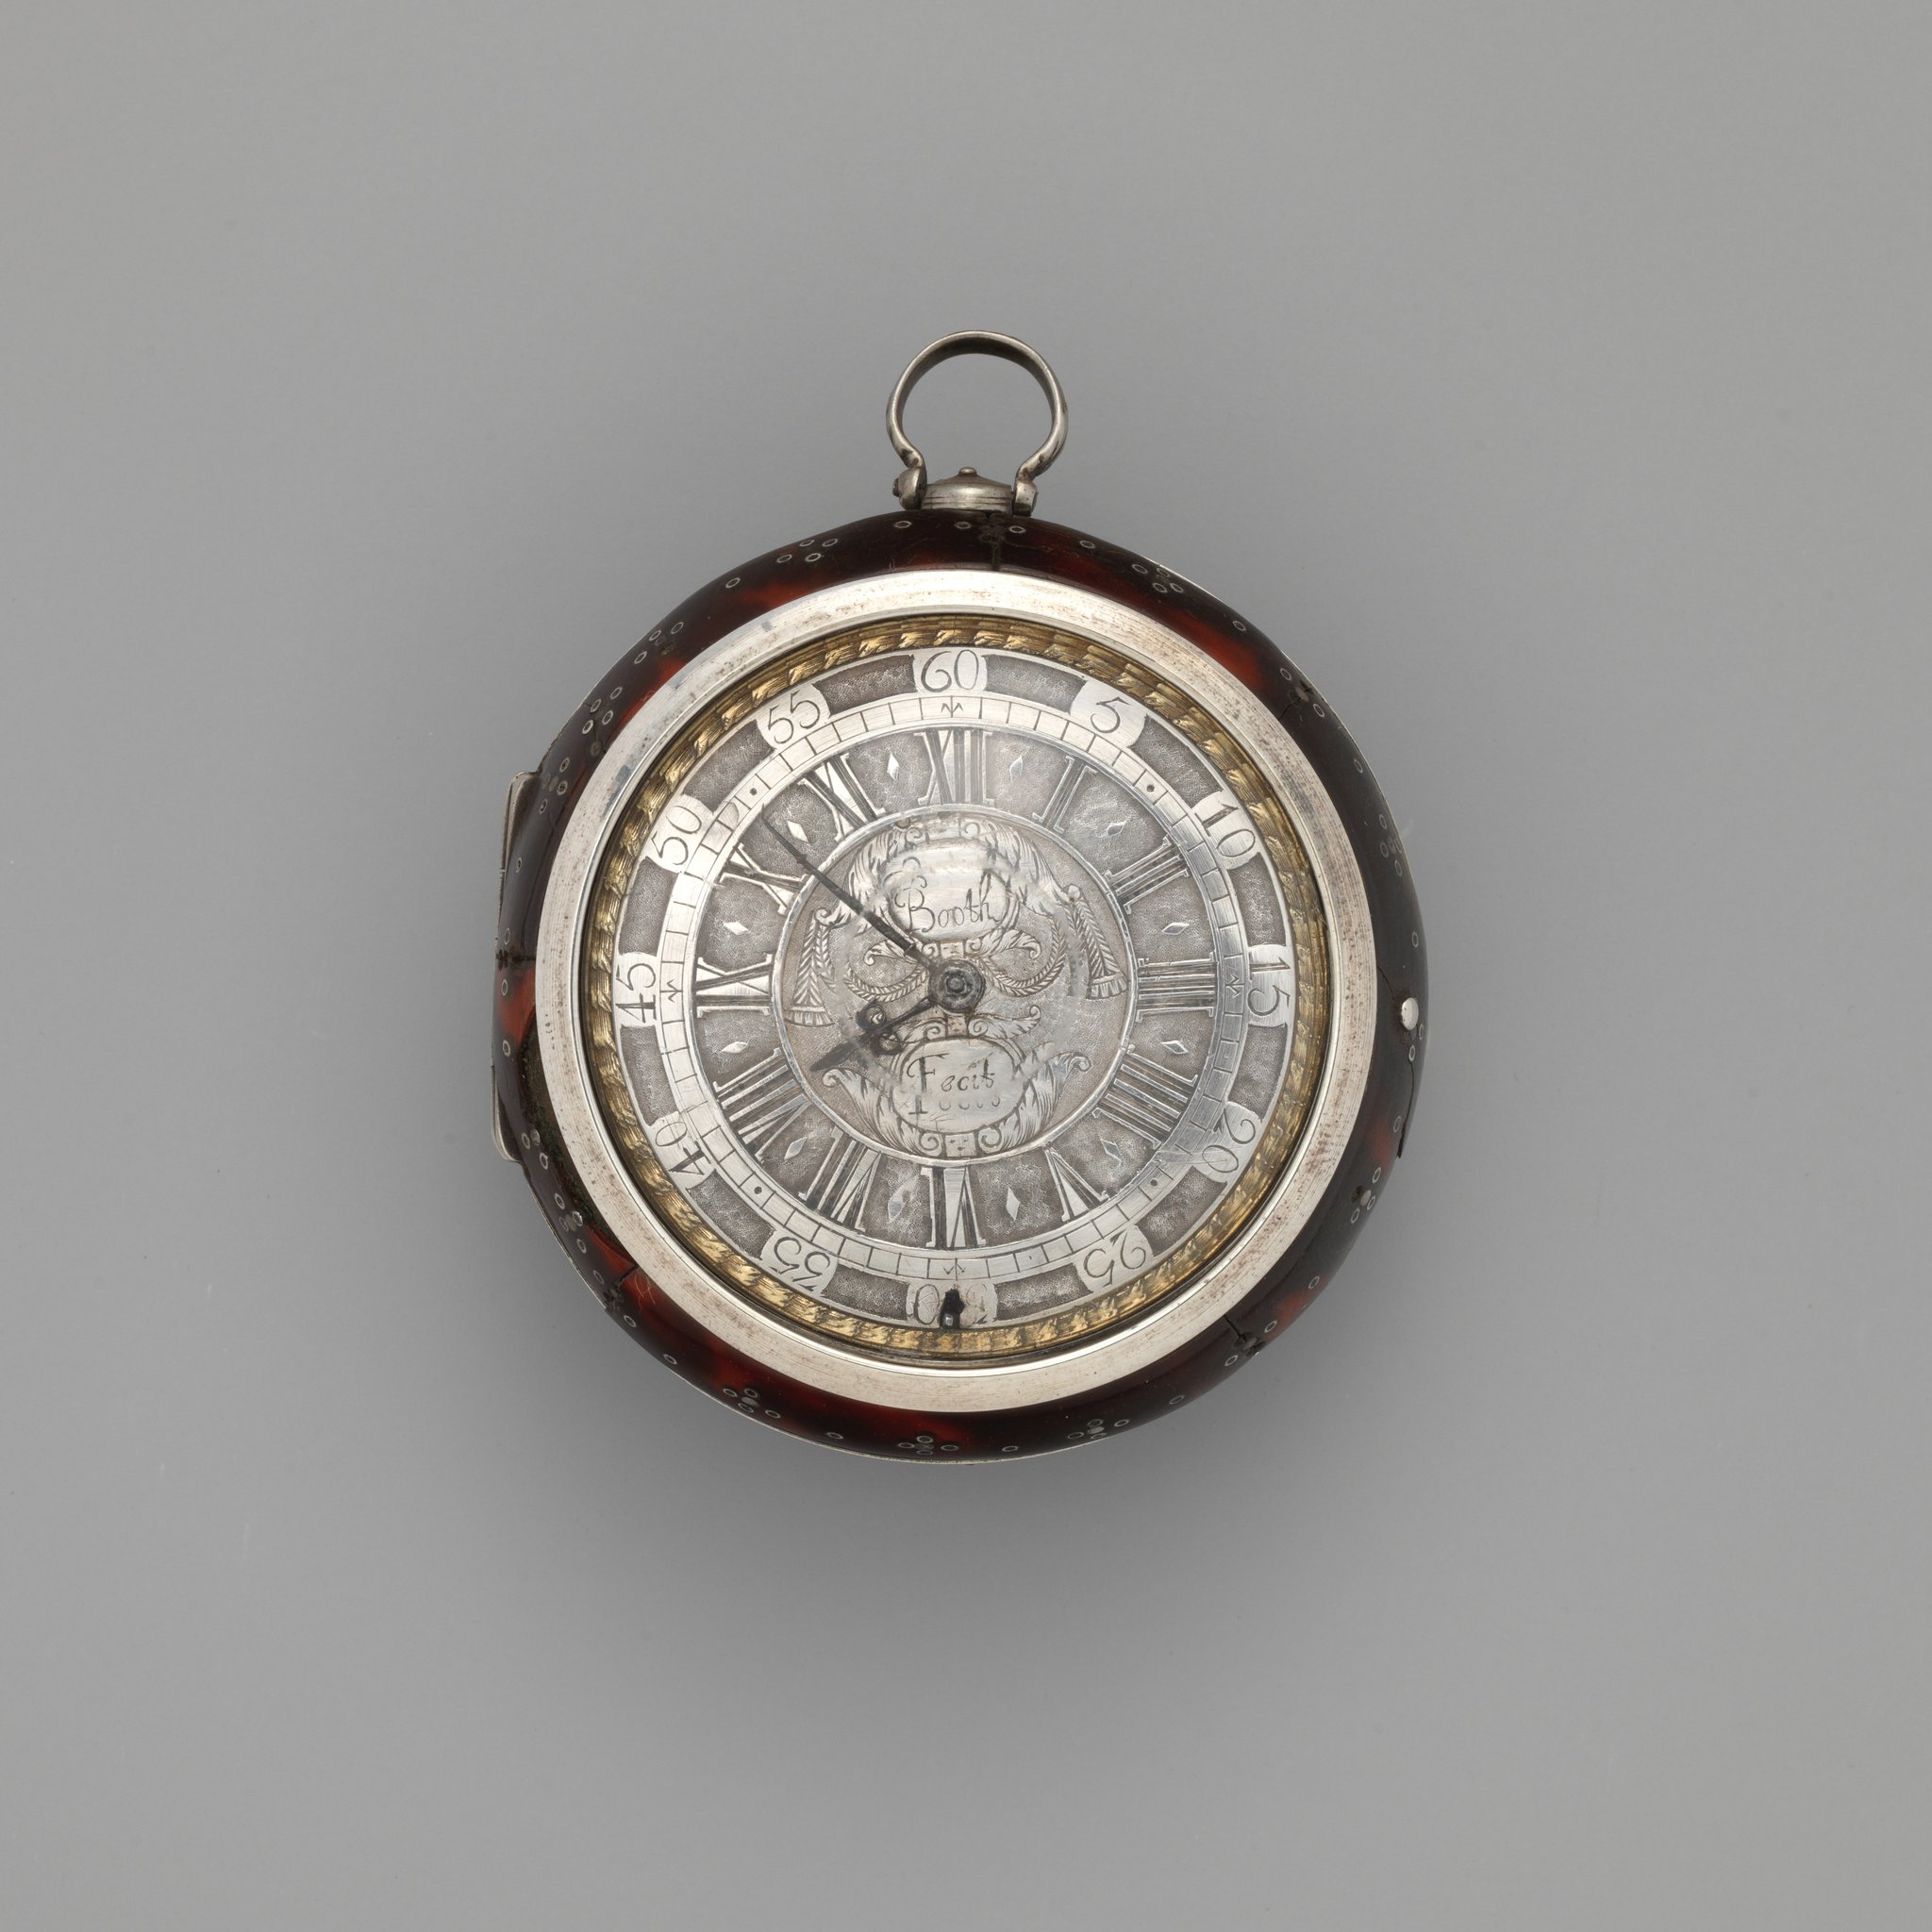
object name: pair case watch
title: Pair-case watch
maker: ben booth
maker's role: maker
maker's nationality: british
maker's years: 1775-1785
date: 1780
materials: gilt, metal, silver, shell